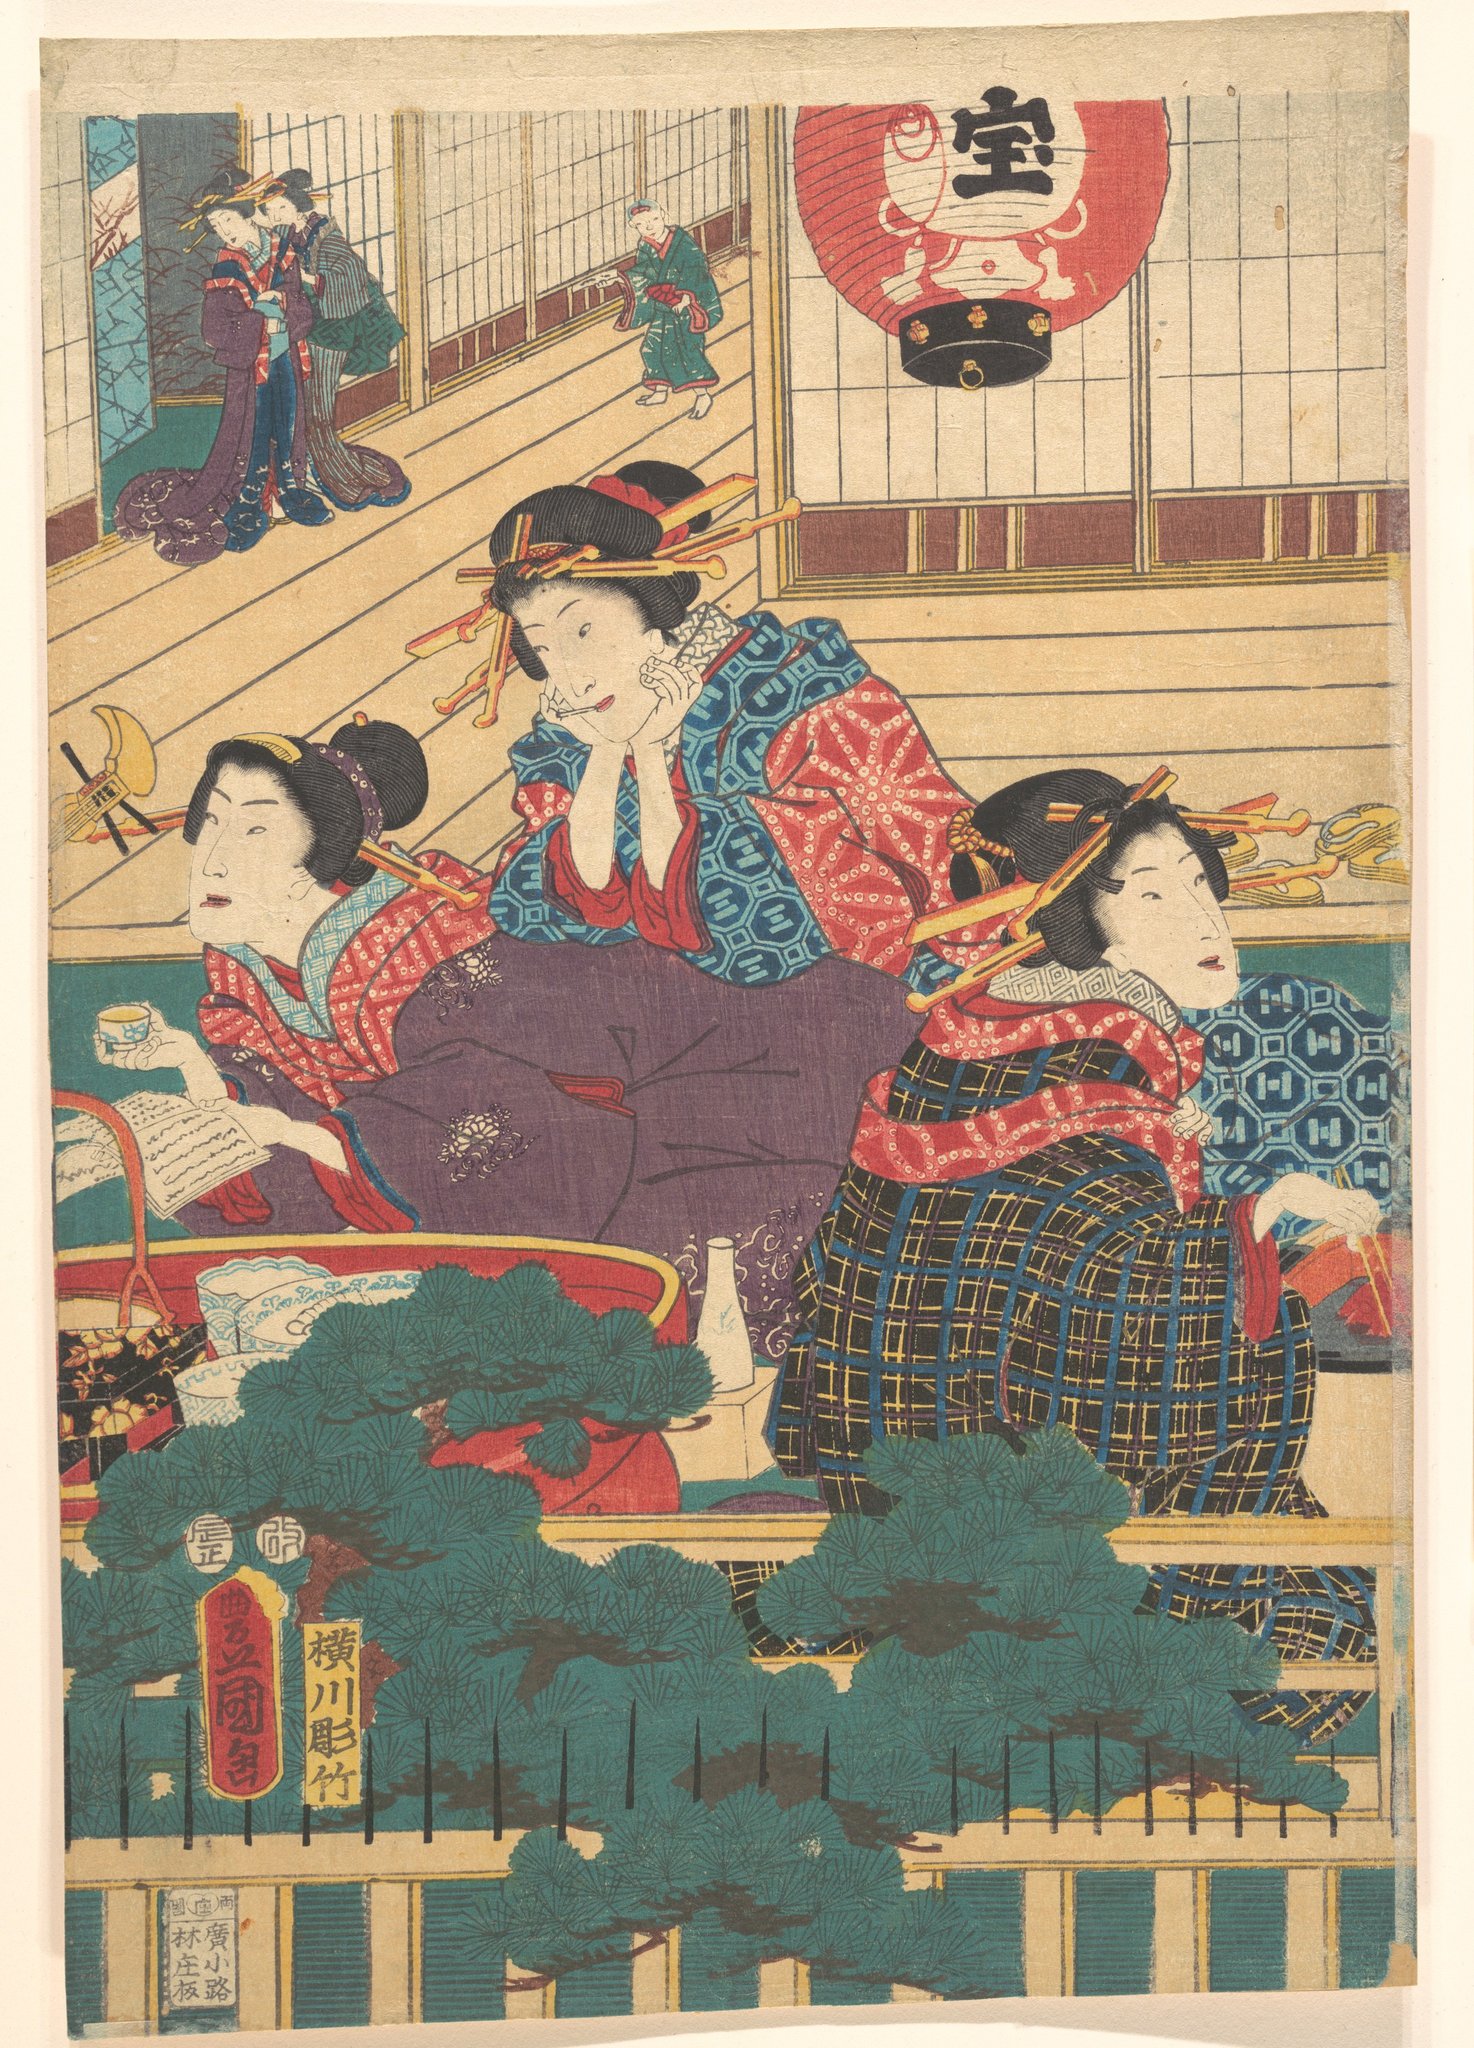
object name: print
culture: japanese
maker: utagawa kunisada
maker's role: artist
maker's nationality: japanese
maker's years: 1786-1864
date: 1786-1854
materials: ink, paper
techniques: woodblock print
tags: women,reading,plants